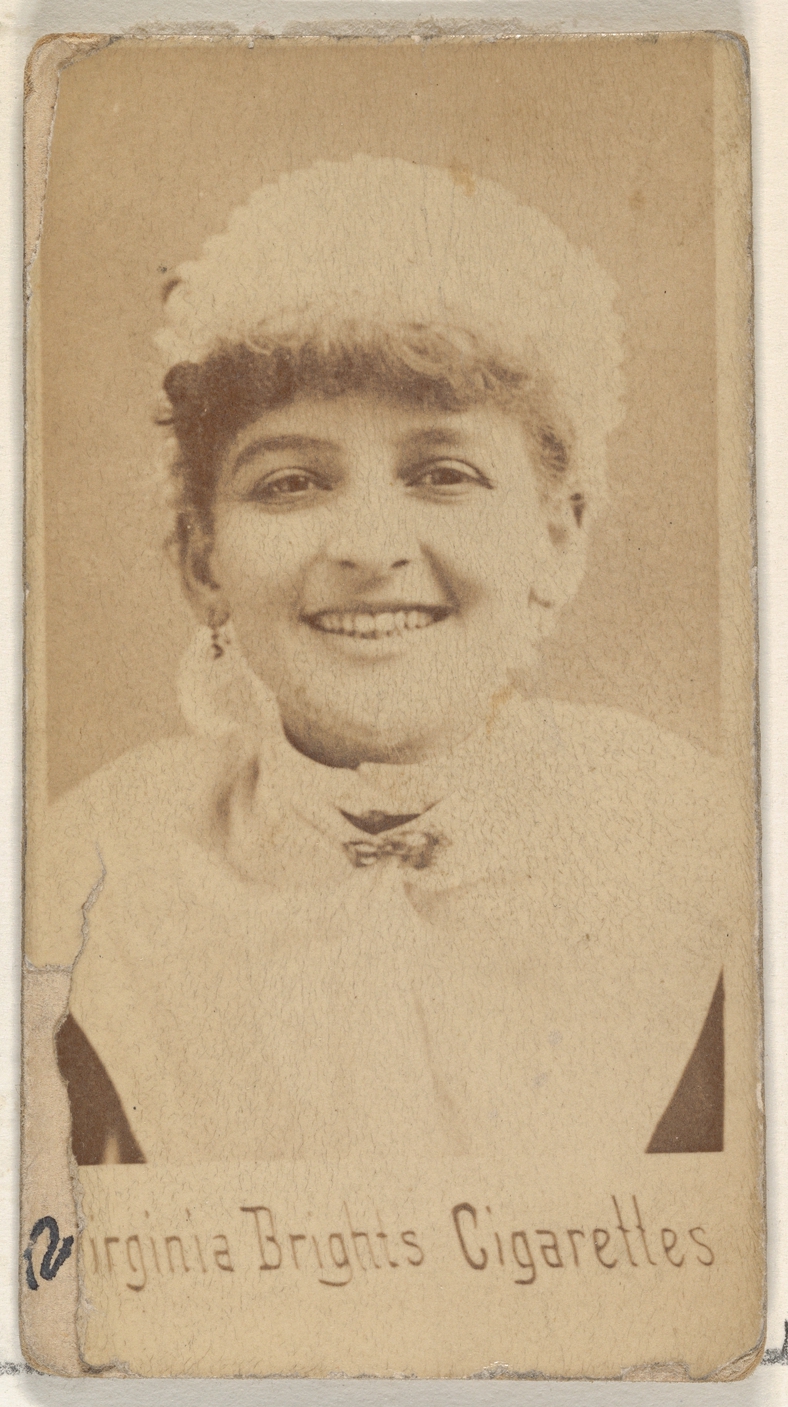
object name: photograph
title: From the Actors and Actresses series (N45, Type 4) for Virginia Brights Cigarettes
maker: allen & ginter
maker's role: publisher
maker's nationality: american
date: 1888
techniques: albumen silver print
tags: portraits,women,actresses